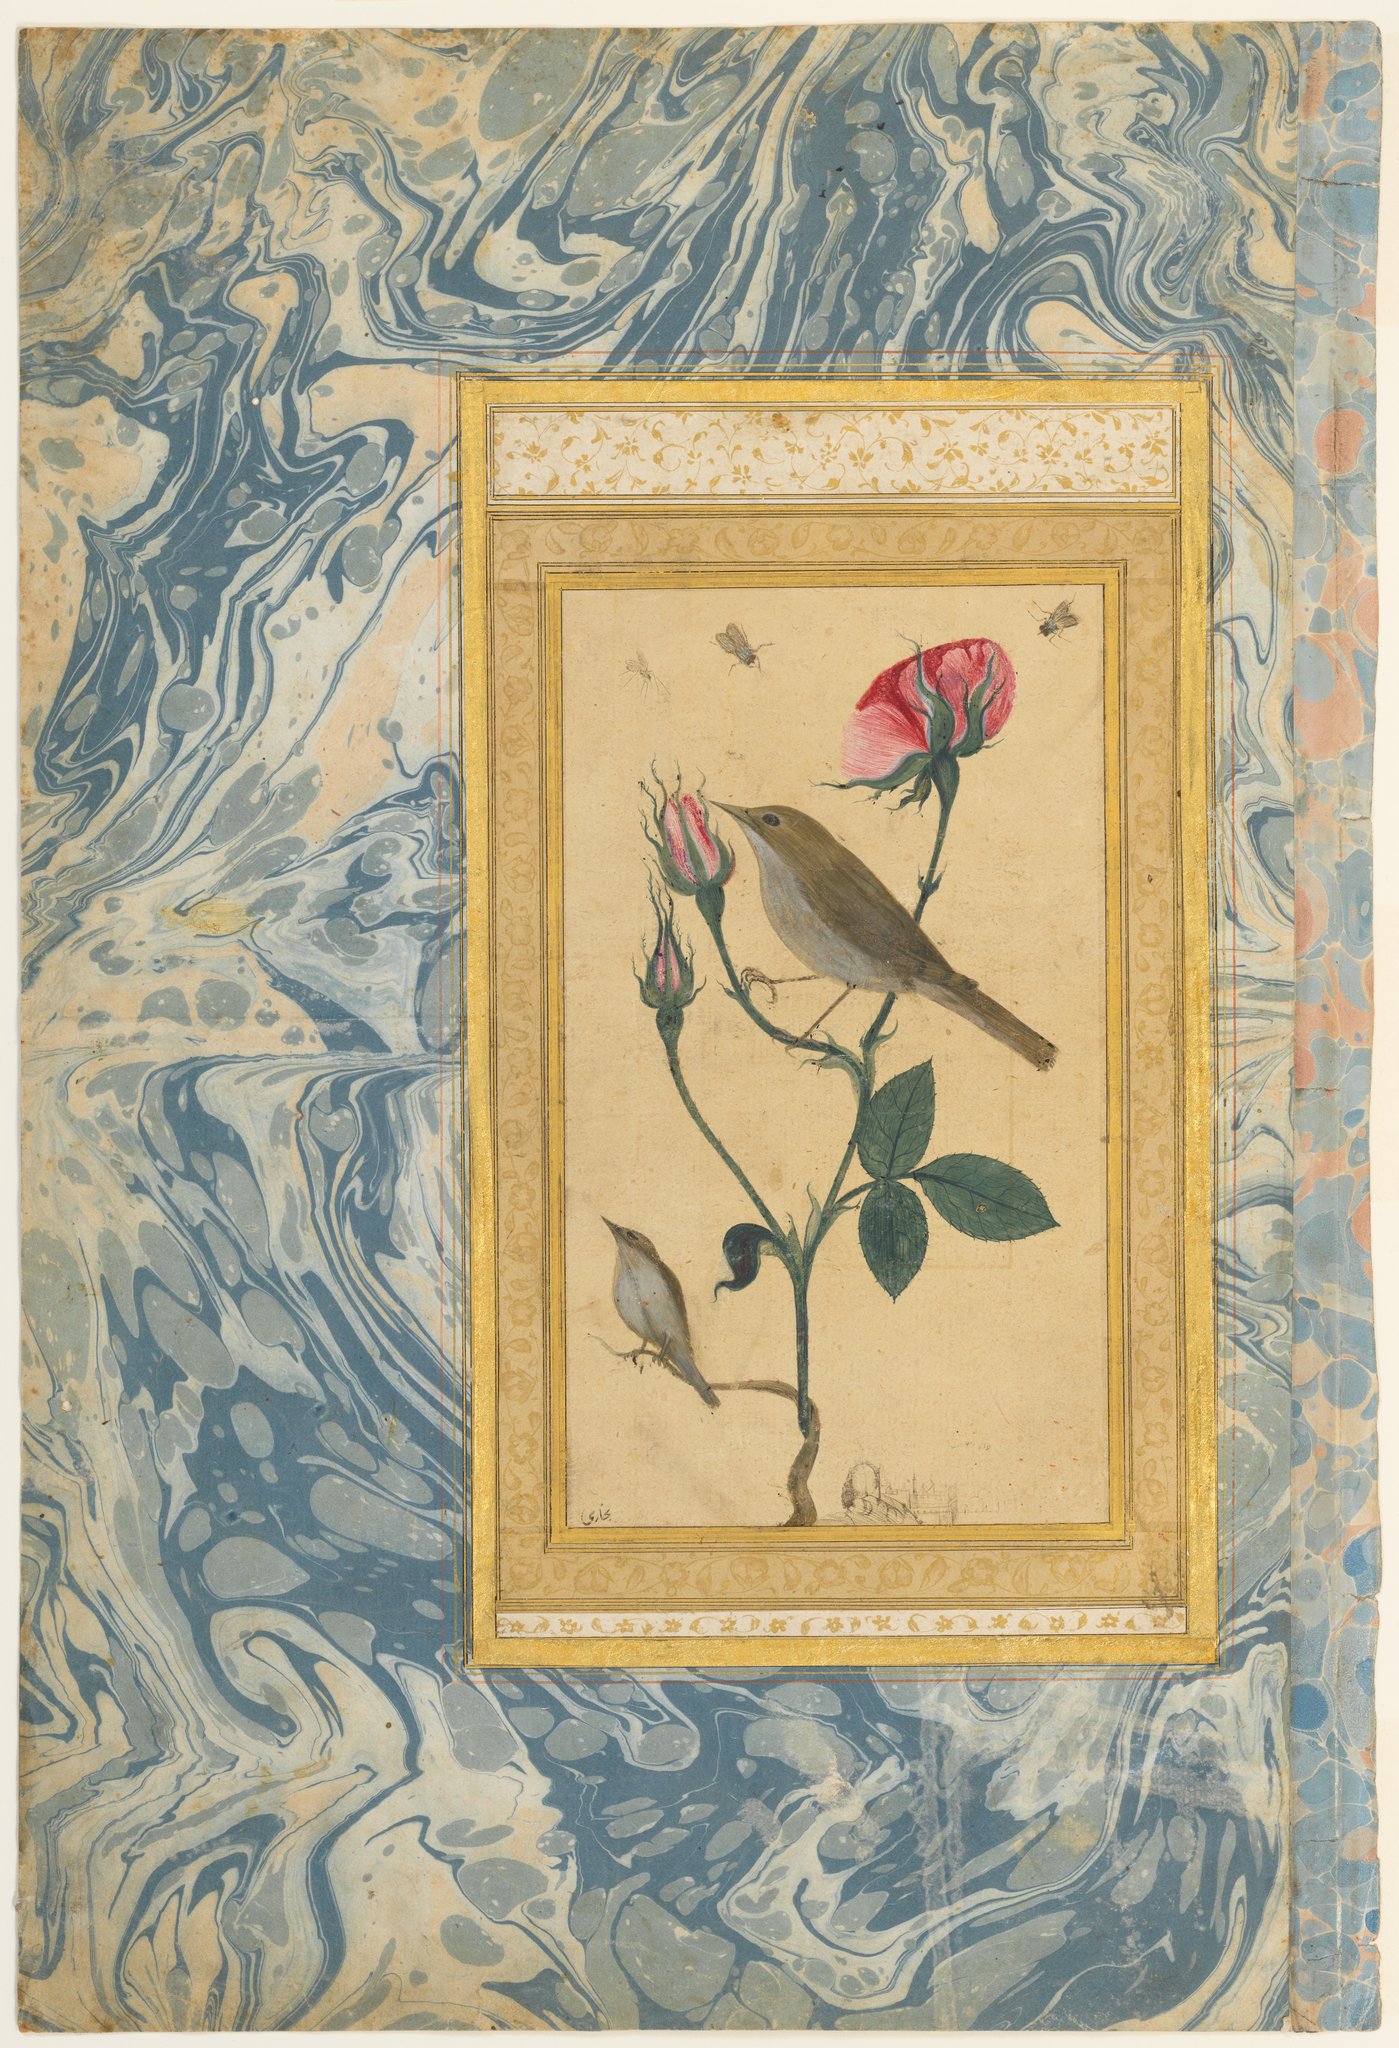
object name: illustrated album leaf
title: "Two Nightingales in a Rose Bush", Double-Sided Illustrated Leaf from an Ottoman Album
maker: 'abdullah bukhari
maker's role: artist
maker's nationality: turkish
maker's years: 1700-1775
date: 1725-1745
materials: gold leaf, ink, paper, shell, watercolor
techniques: marbling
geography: turkey